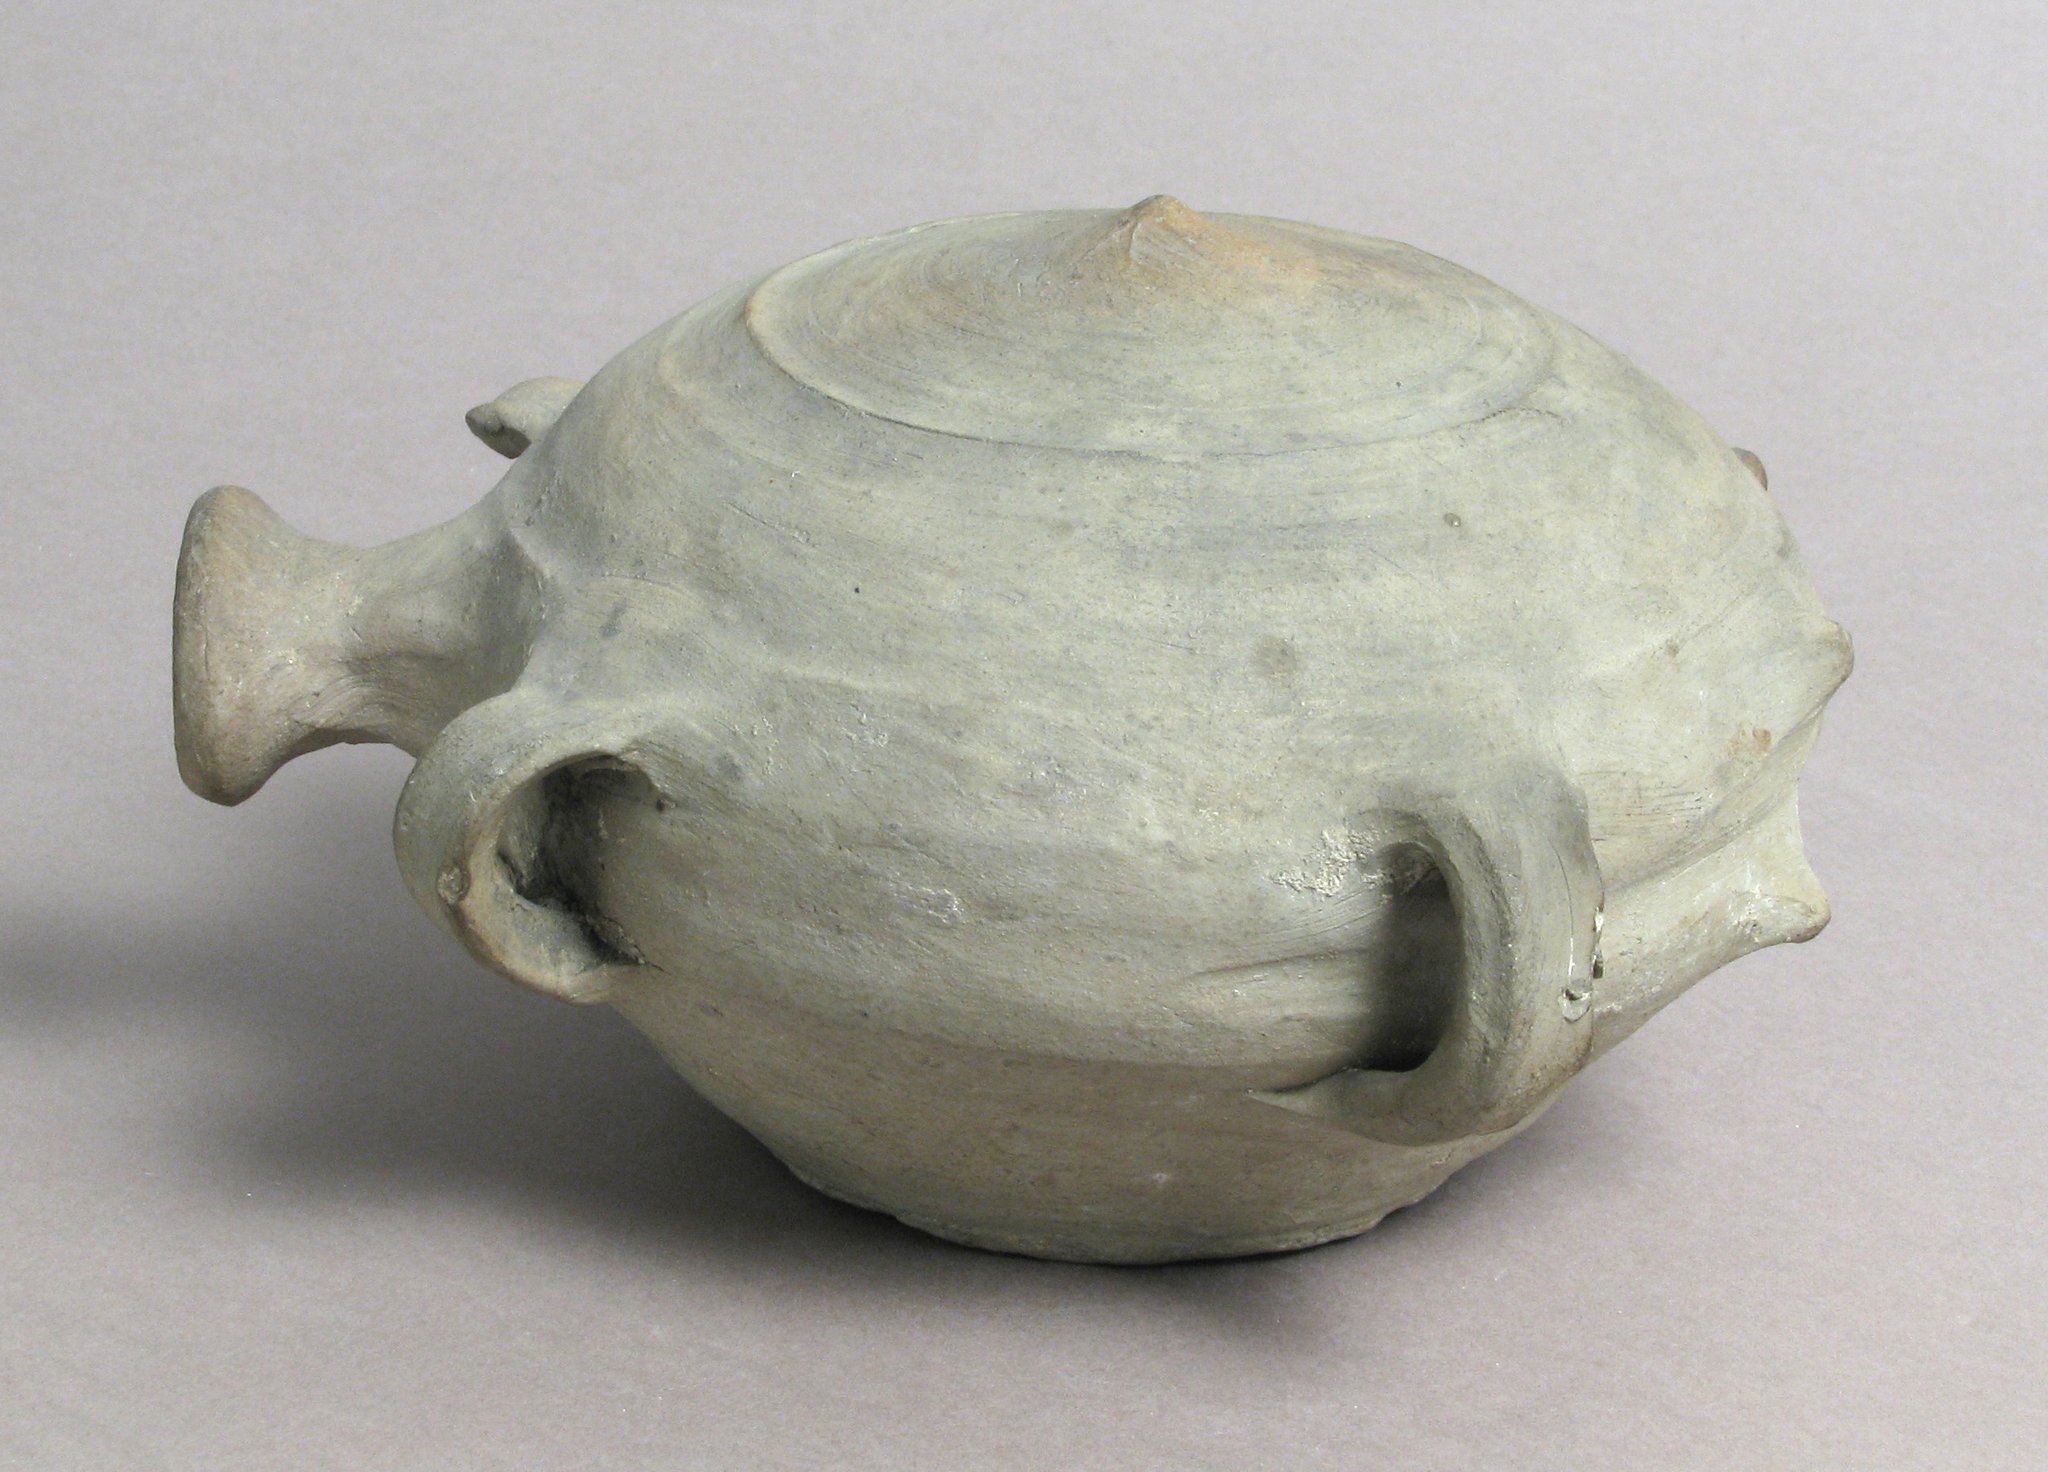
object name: pilgrim bottle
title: Bottle, Pilgrim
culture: french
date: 1401-1500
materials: earthenware